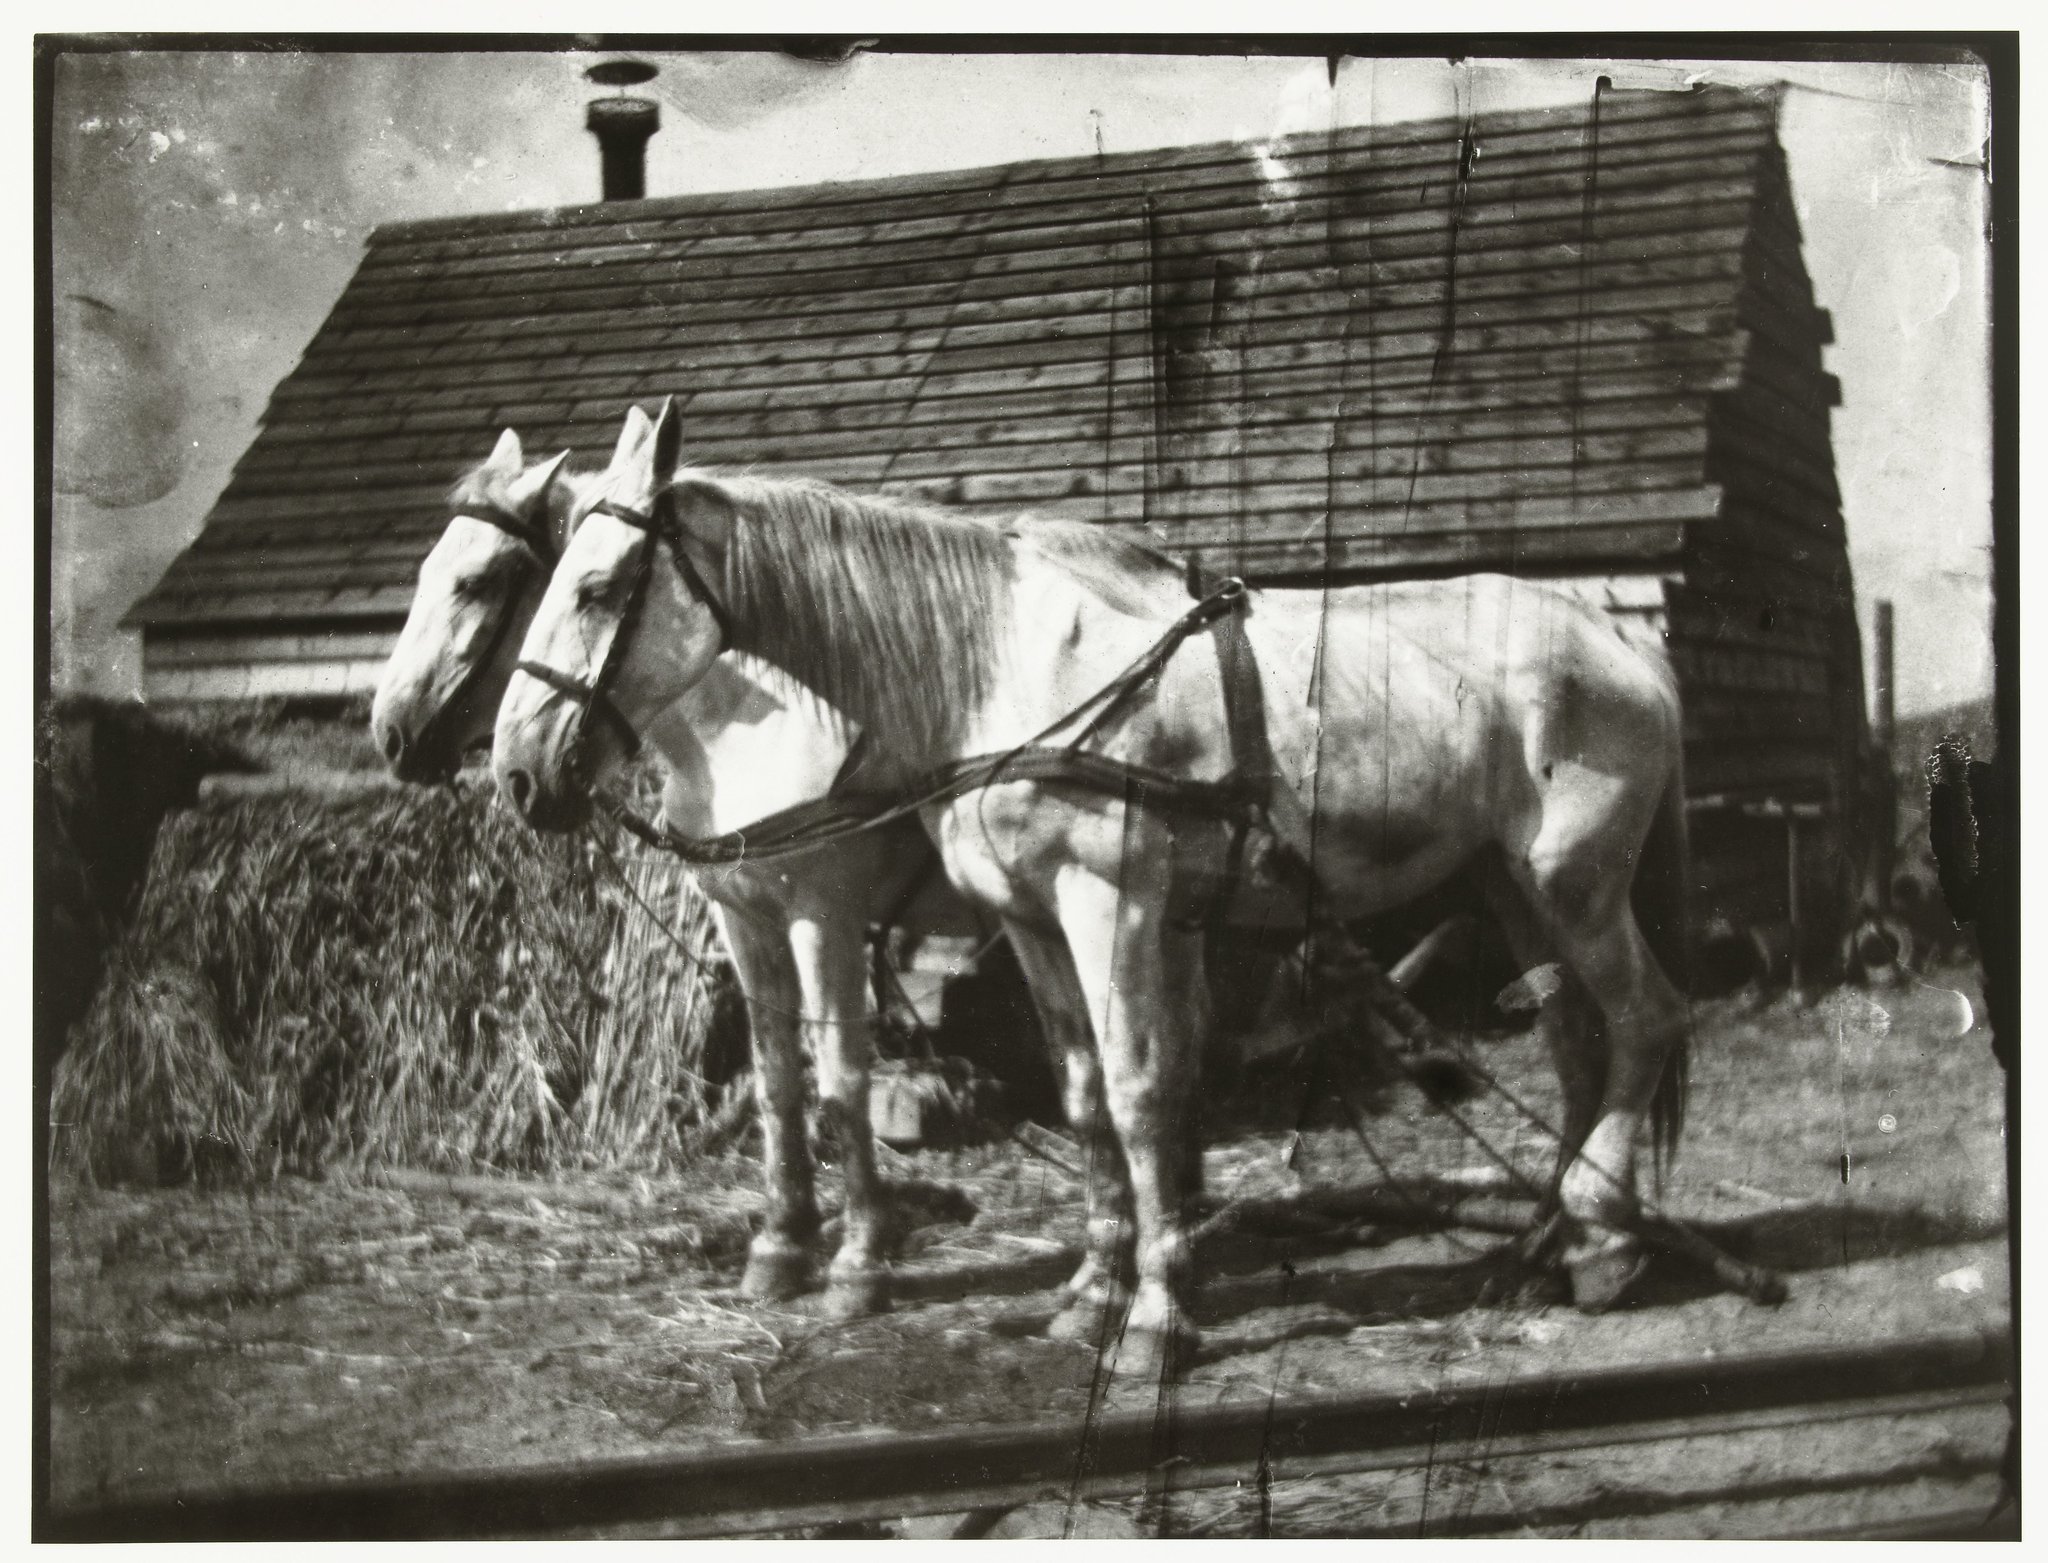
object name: photograph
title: Paarden aan de Cruquiusweg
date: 1890-1910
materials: paper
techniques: gelatin silver print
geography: netherlands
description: Moderne afdruk van negatief BR 1614 (collectie RKD).